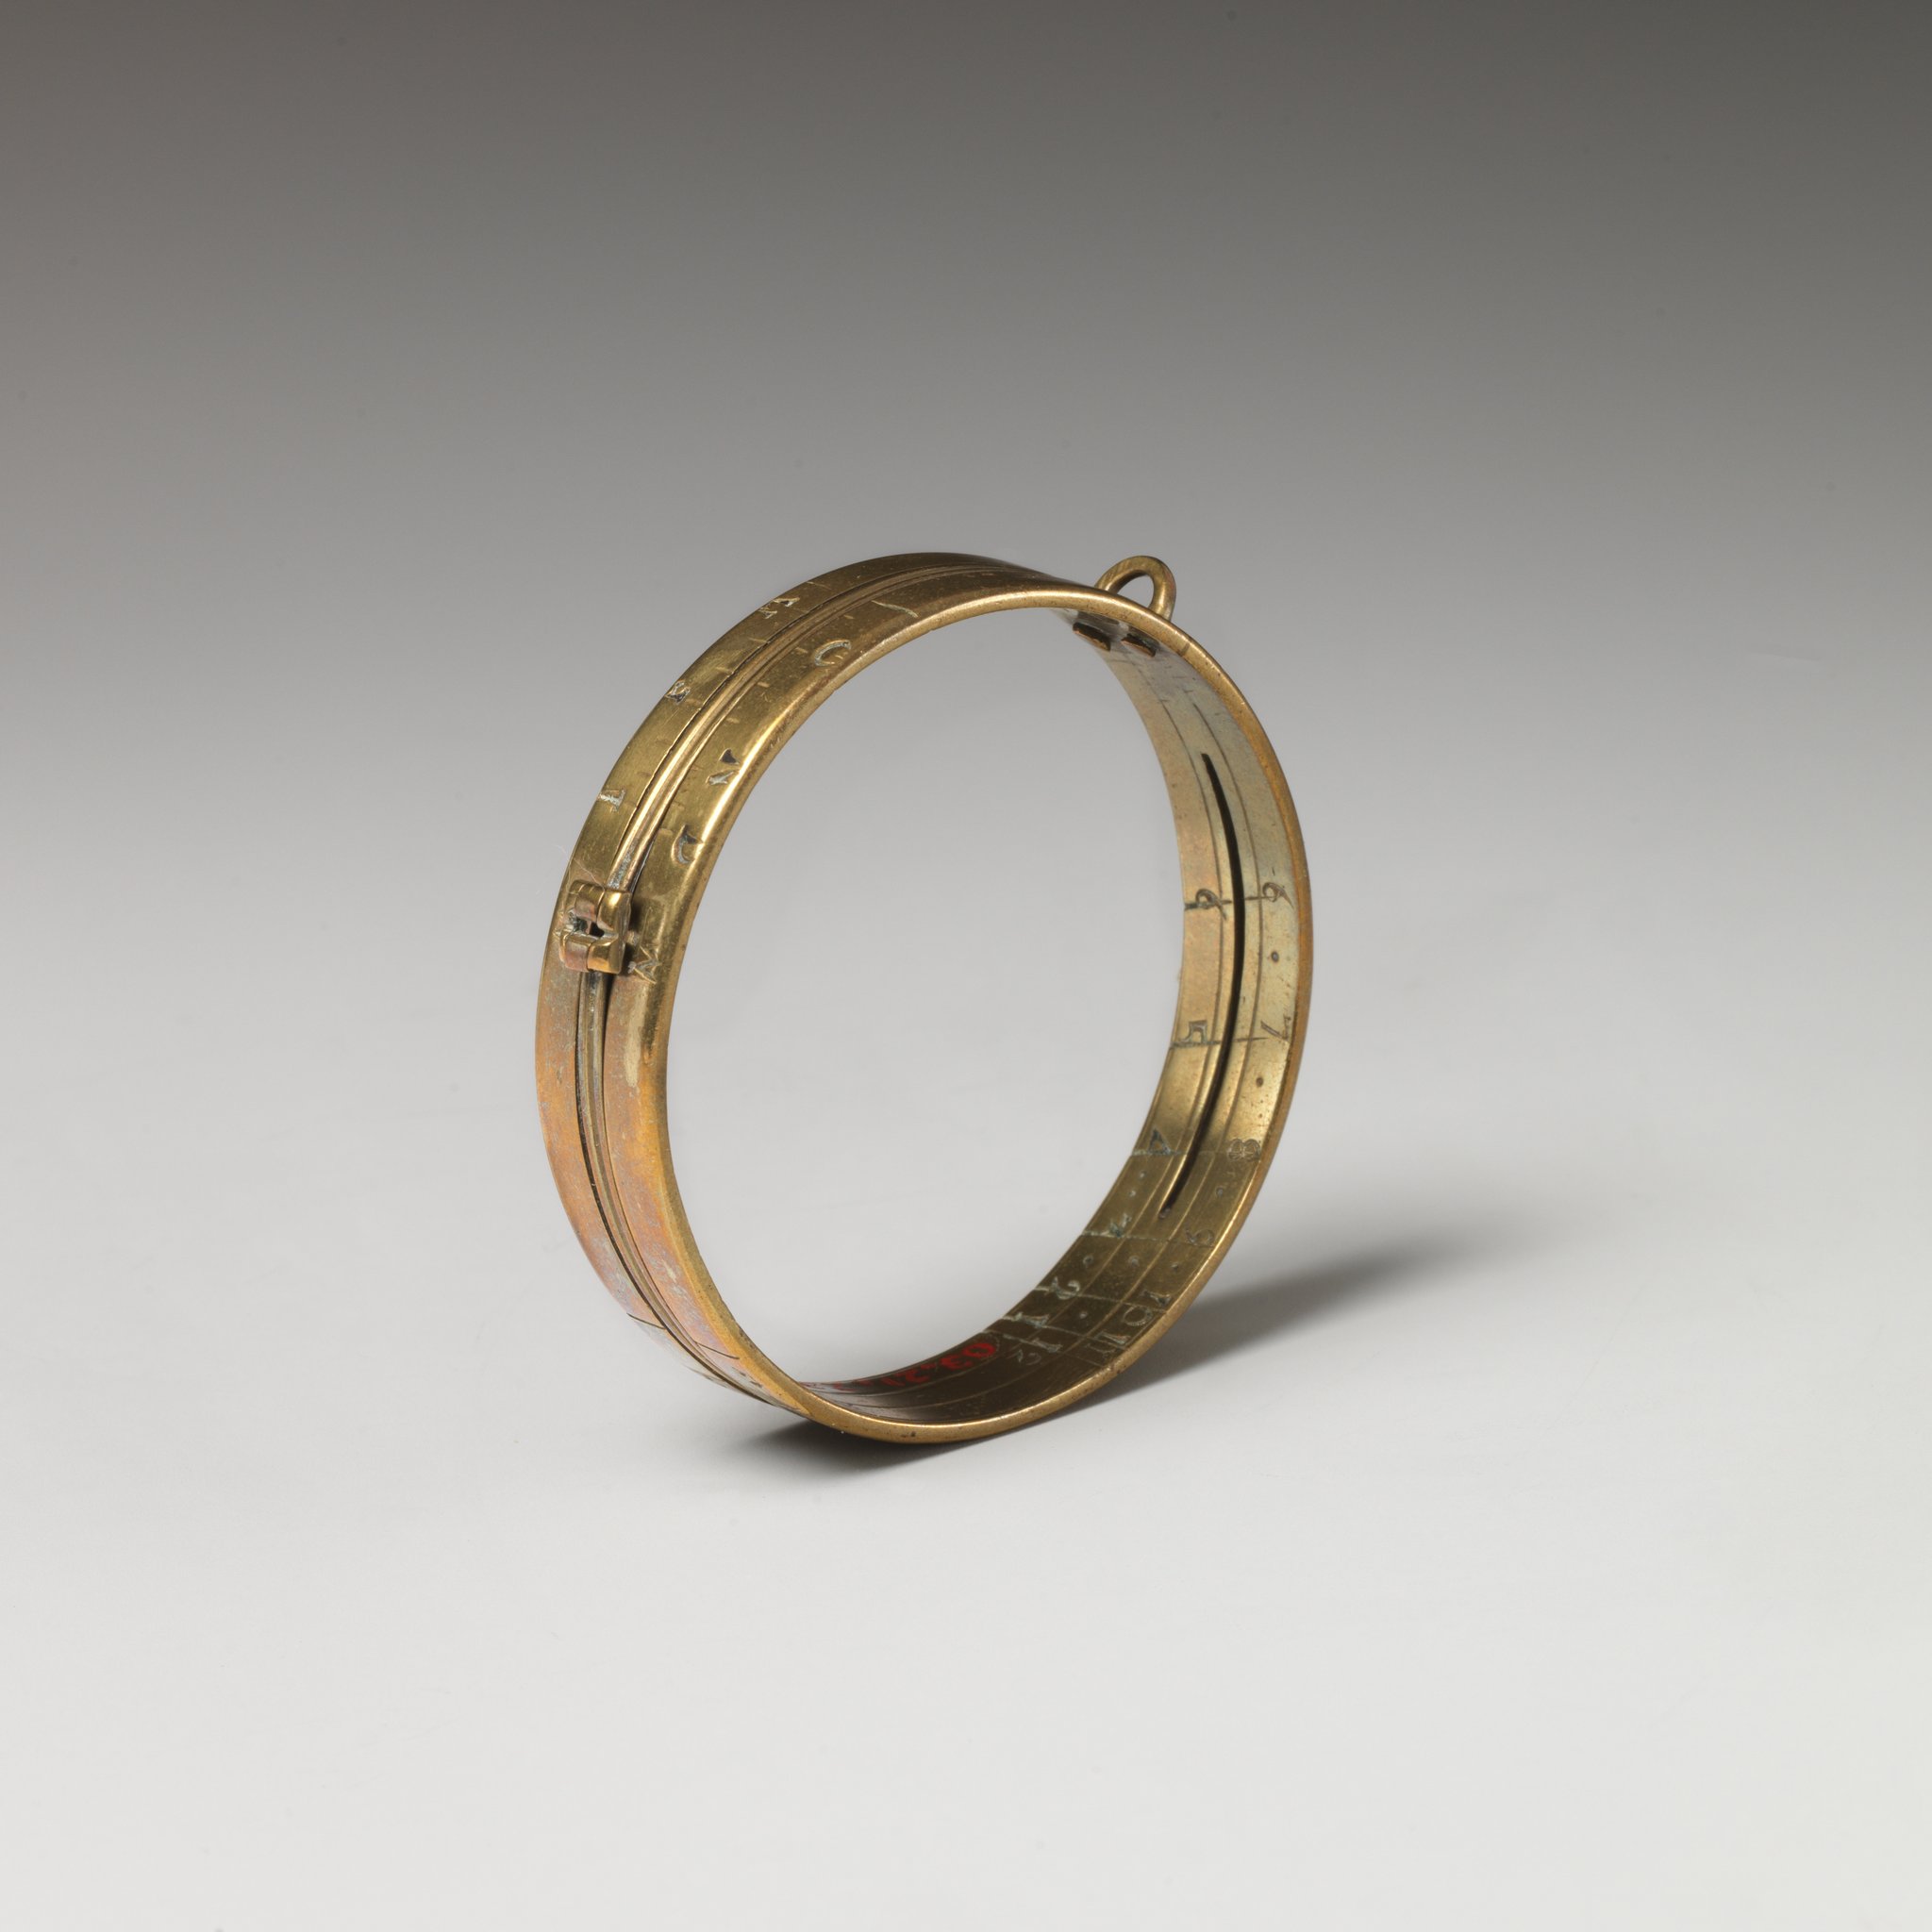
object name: ring dial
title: Local ring dial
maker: t. w.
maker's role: maker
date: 1601-1700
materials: brass